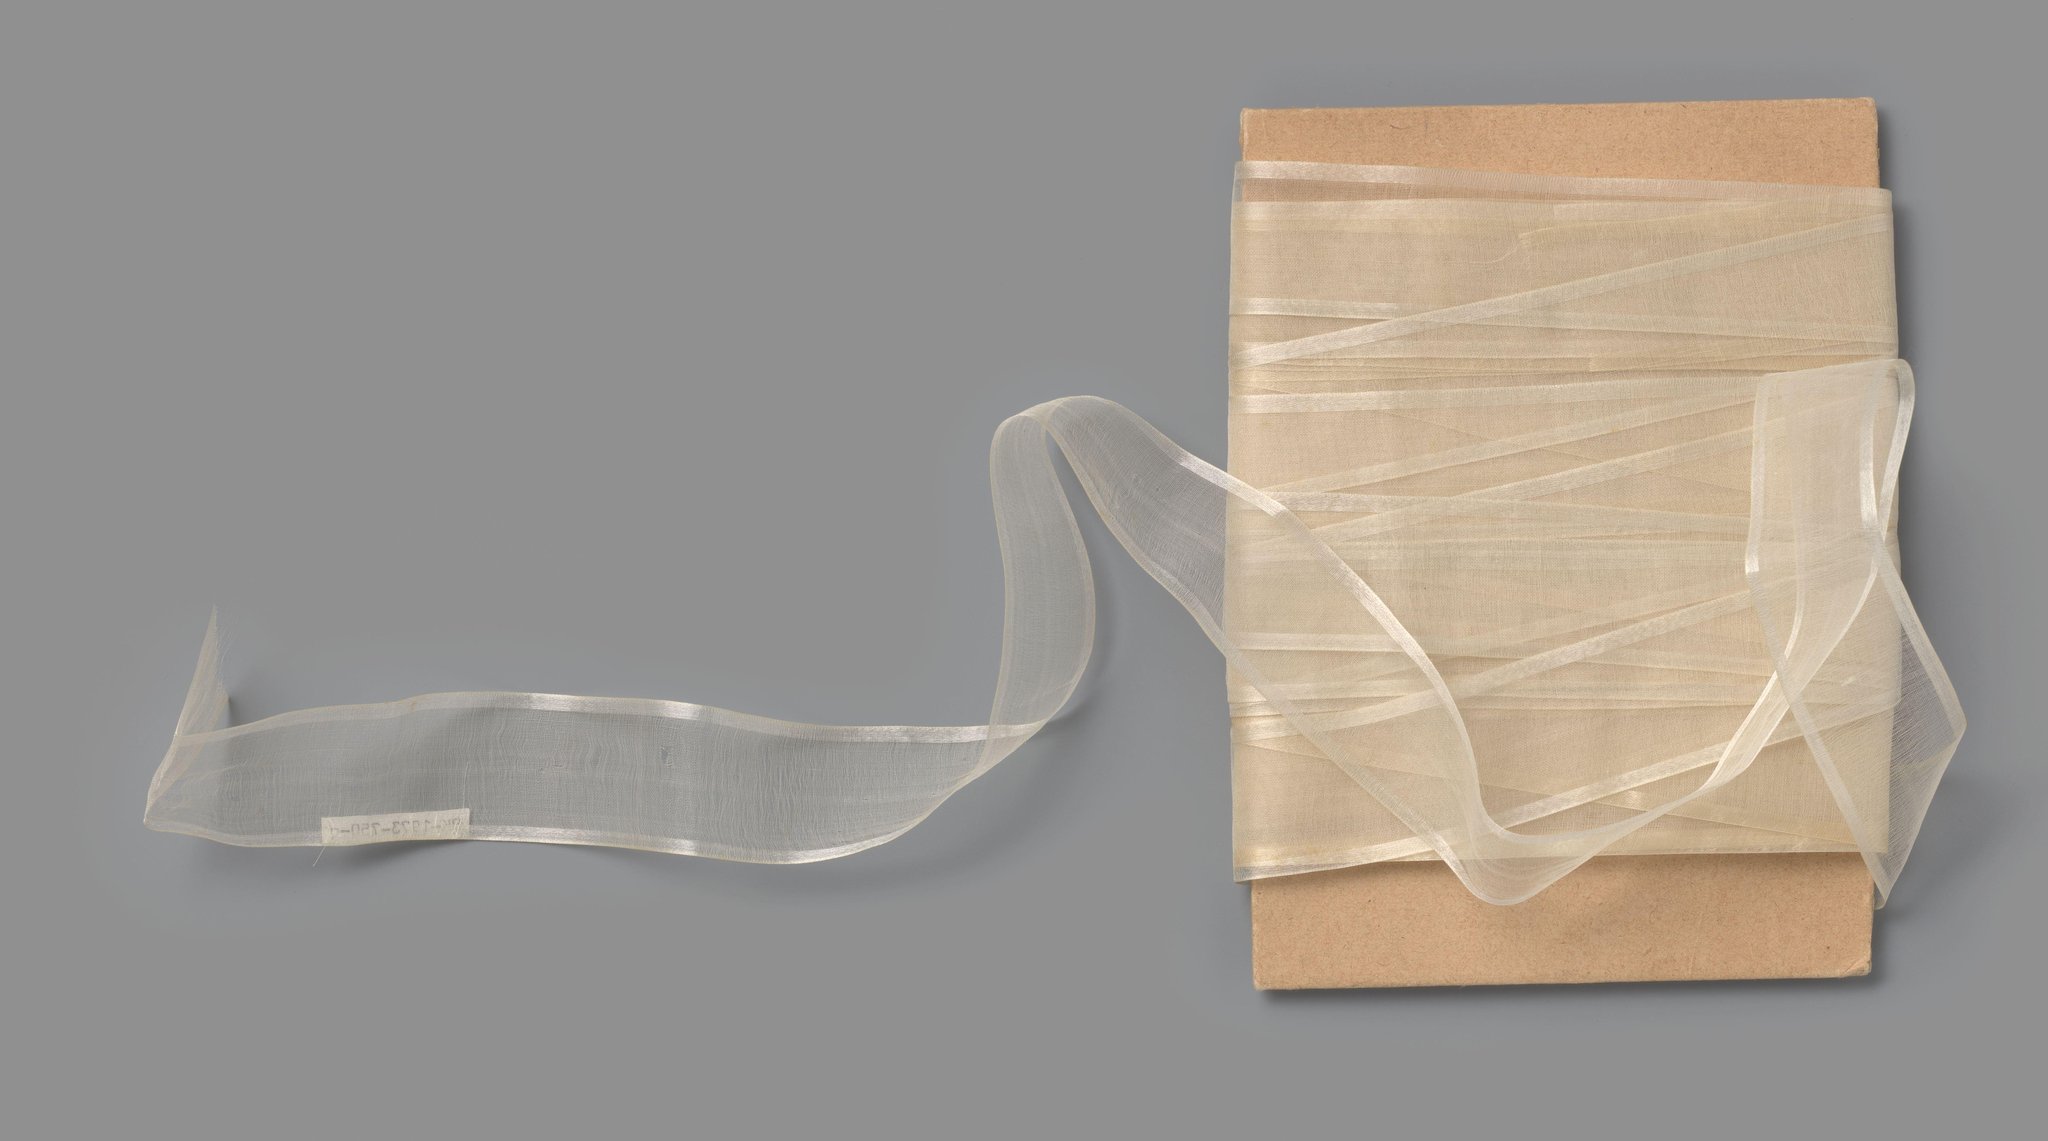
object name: braid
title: Karton waarop crème-wit lint van effen zijden gaas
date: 1900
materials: silk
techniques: weave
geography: france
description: Karton waarop crème-wit lint van effen zijden gaas.